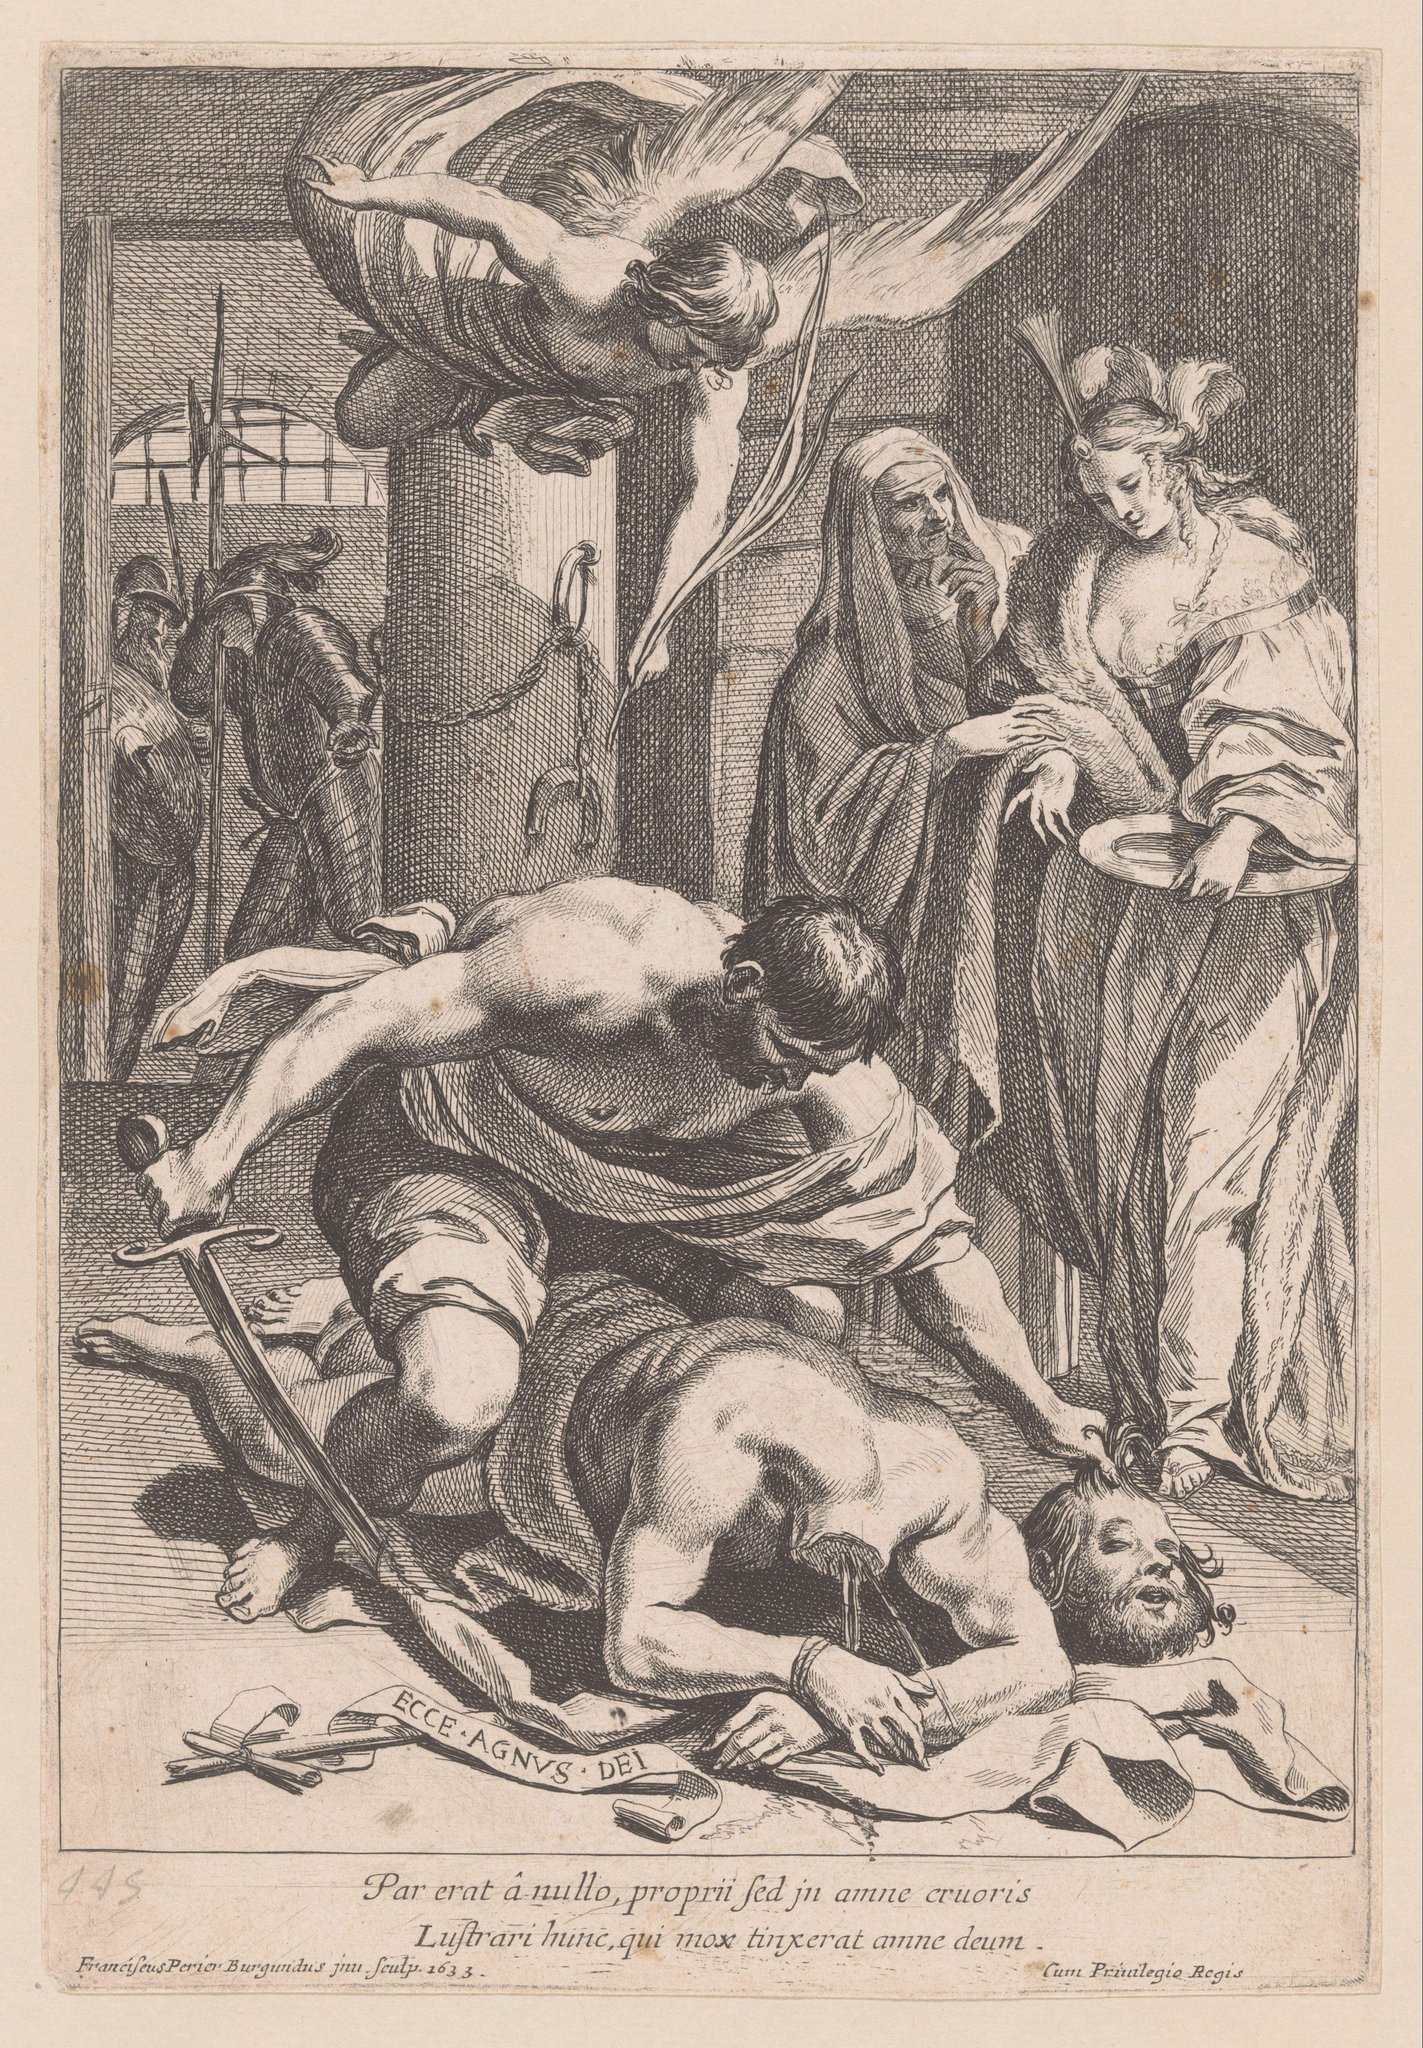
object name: print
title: Onthoofding van Johannes de Doper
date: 1633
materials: paper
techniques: etching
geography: france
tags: the beheading of john the baptist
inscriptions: collector's mark: Lugt 240